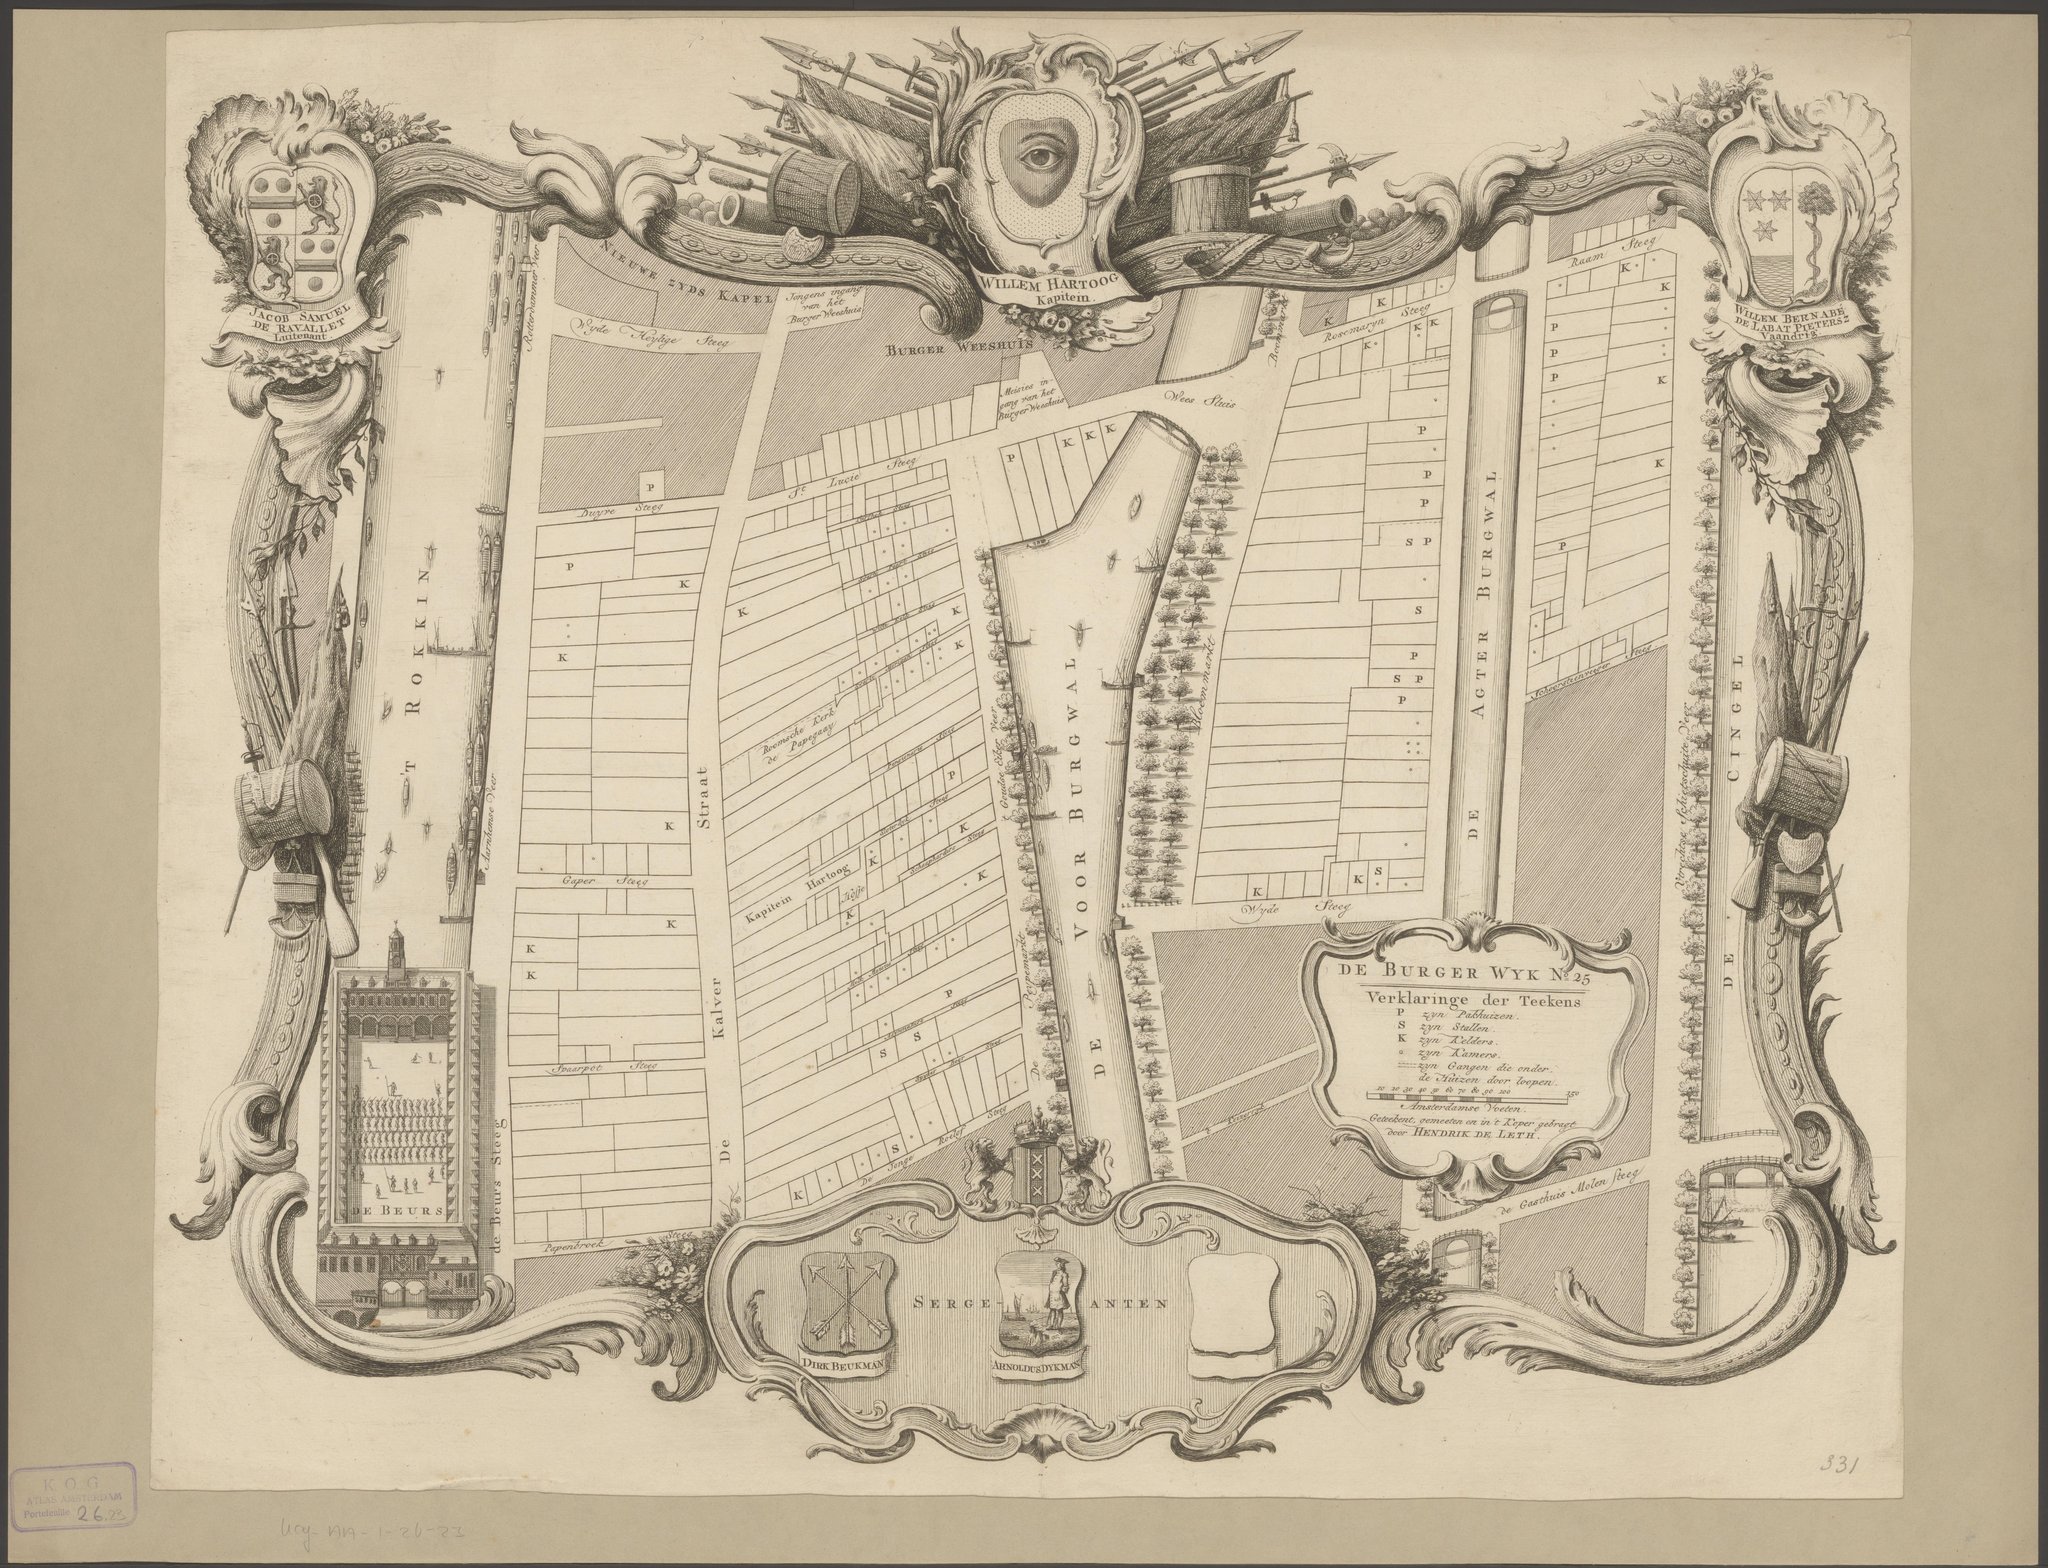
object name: print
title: Plattegrond van burgerwijk XXV te Amsterdam, onder leiding van kapitein Willem Hartoog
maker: hendrik de leth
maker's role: draughtsman, print maker, publisher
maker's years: 1703-1766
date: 1752-1759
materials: paper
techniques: engraving, etching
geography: amsterdam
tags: coat of arms (as symbol of the state, etc.) (+ city; municipal), maps of cities, armorial bearing, heraldry, amsterdam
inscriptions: collector's mark: Lugt 1641b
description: Onderwerpsrubriek binnen de Atlas Amsterdam: Schutterswijkkaarten.